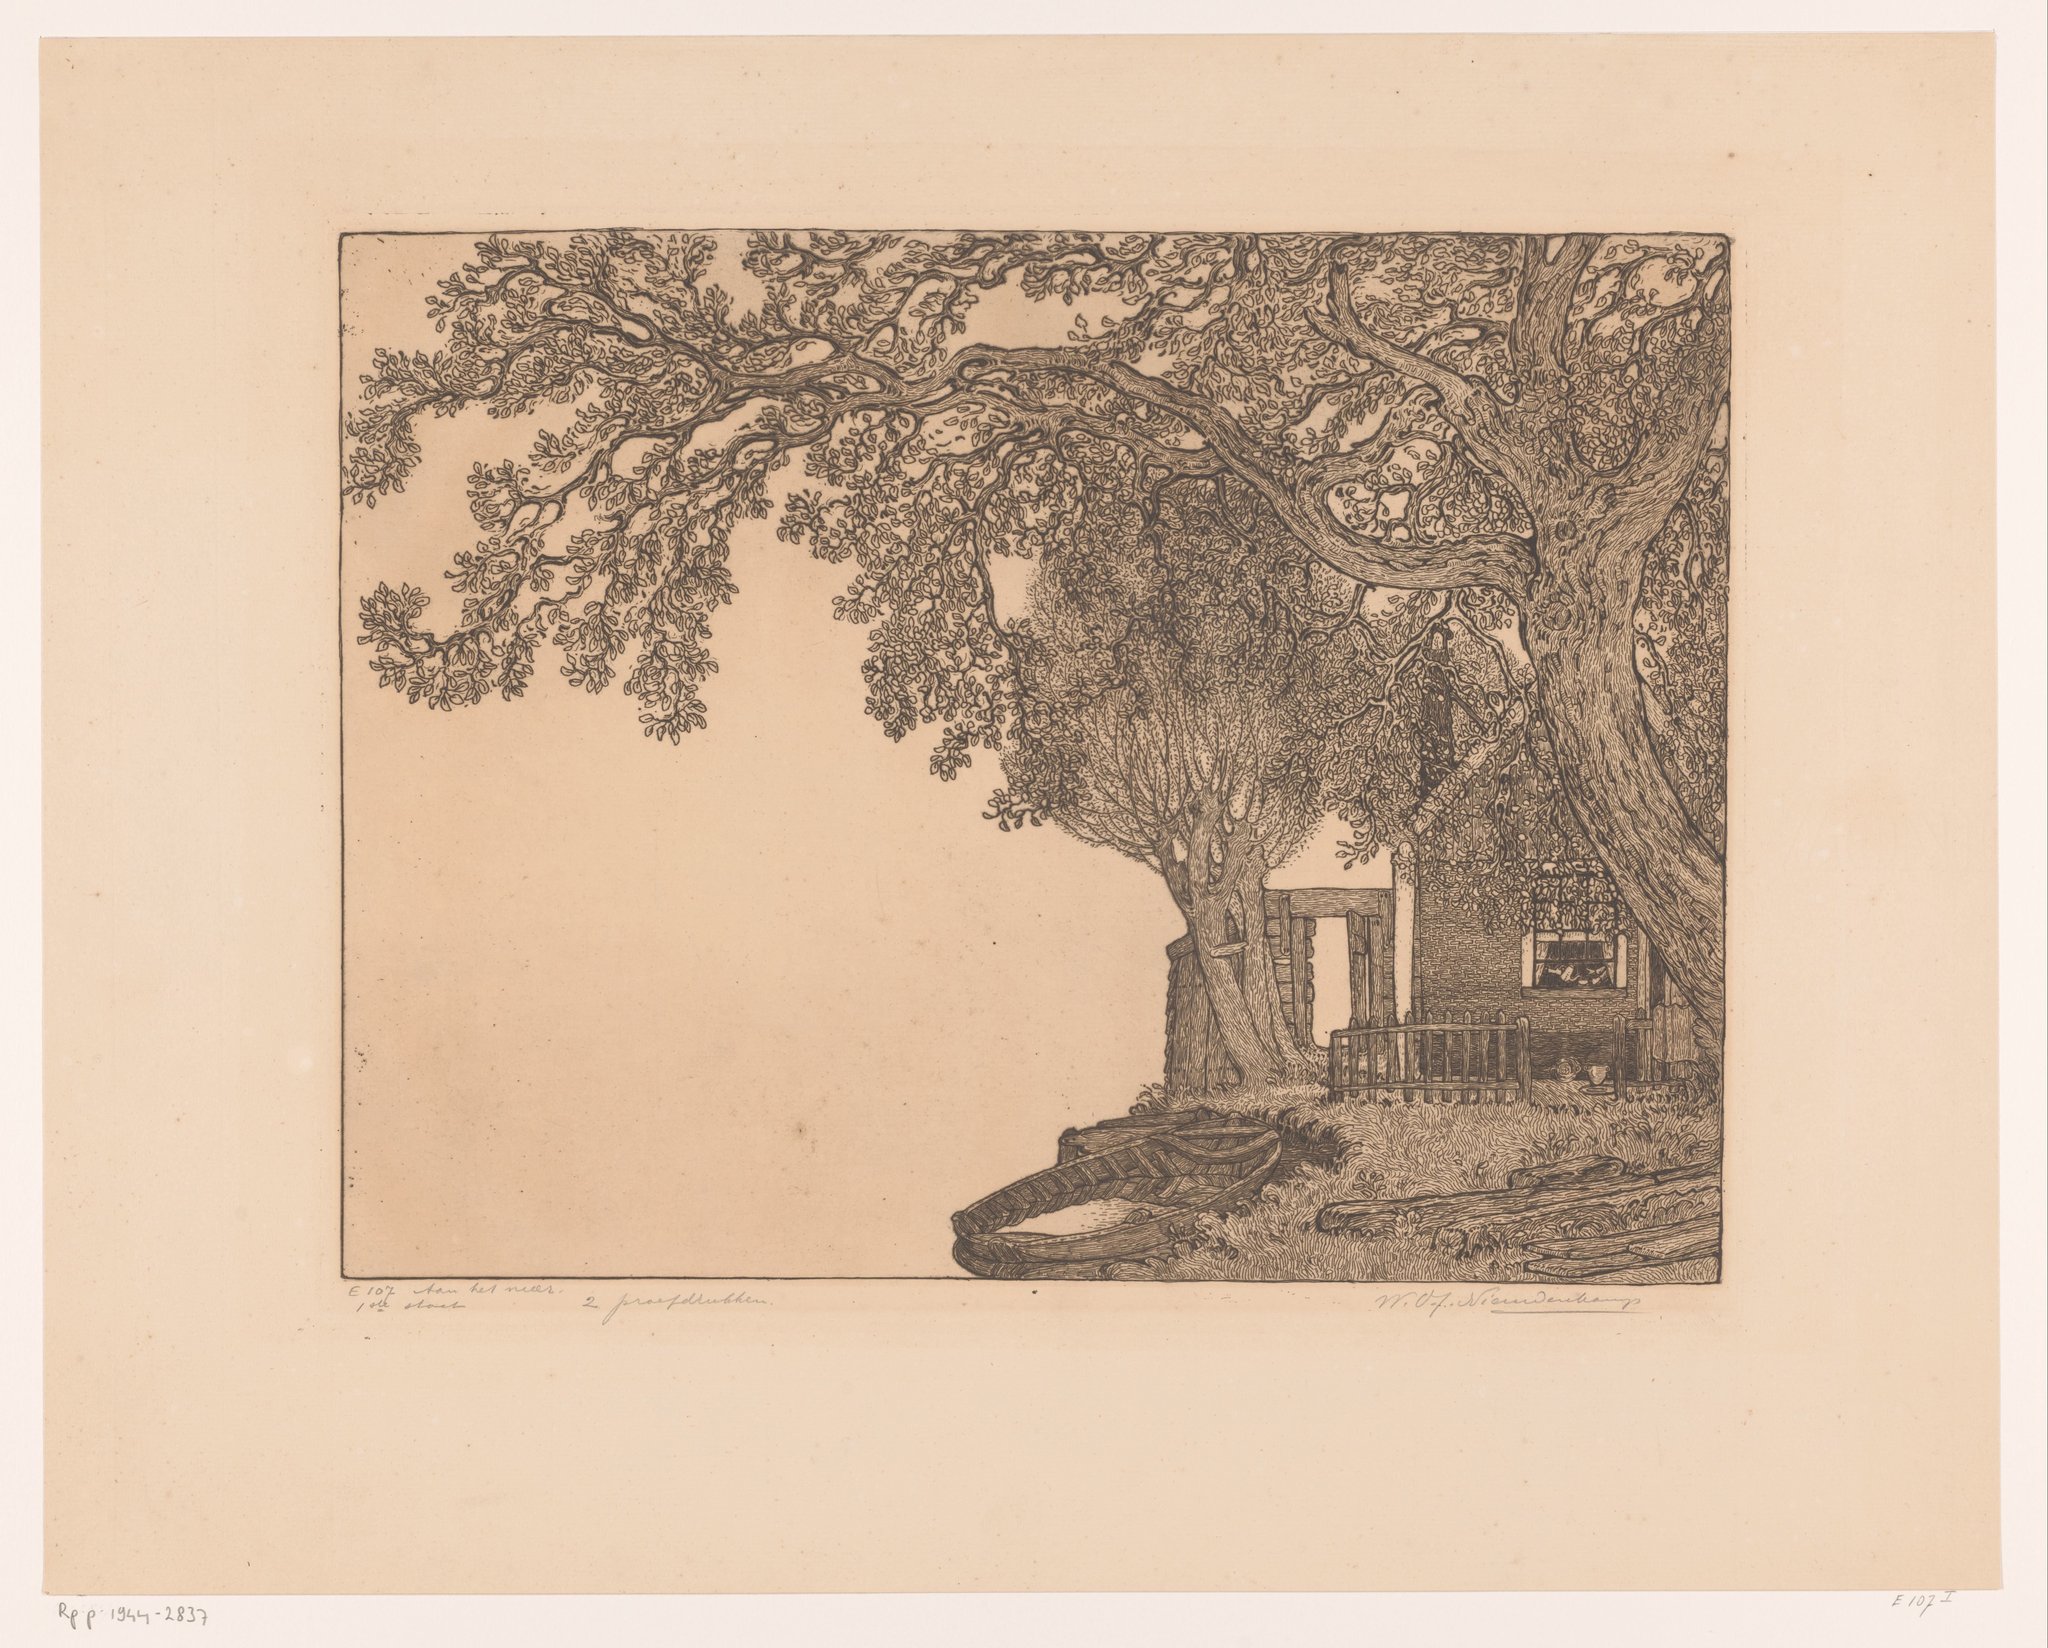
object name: print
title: Aan het meer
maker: wijnand otto jan nieuwenkamp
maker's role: draughtsman, print maker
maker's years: 1874-1950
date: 1909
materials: paper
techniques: etching, intaglio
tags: lake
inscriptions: collector's mark: Lugt 2228